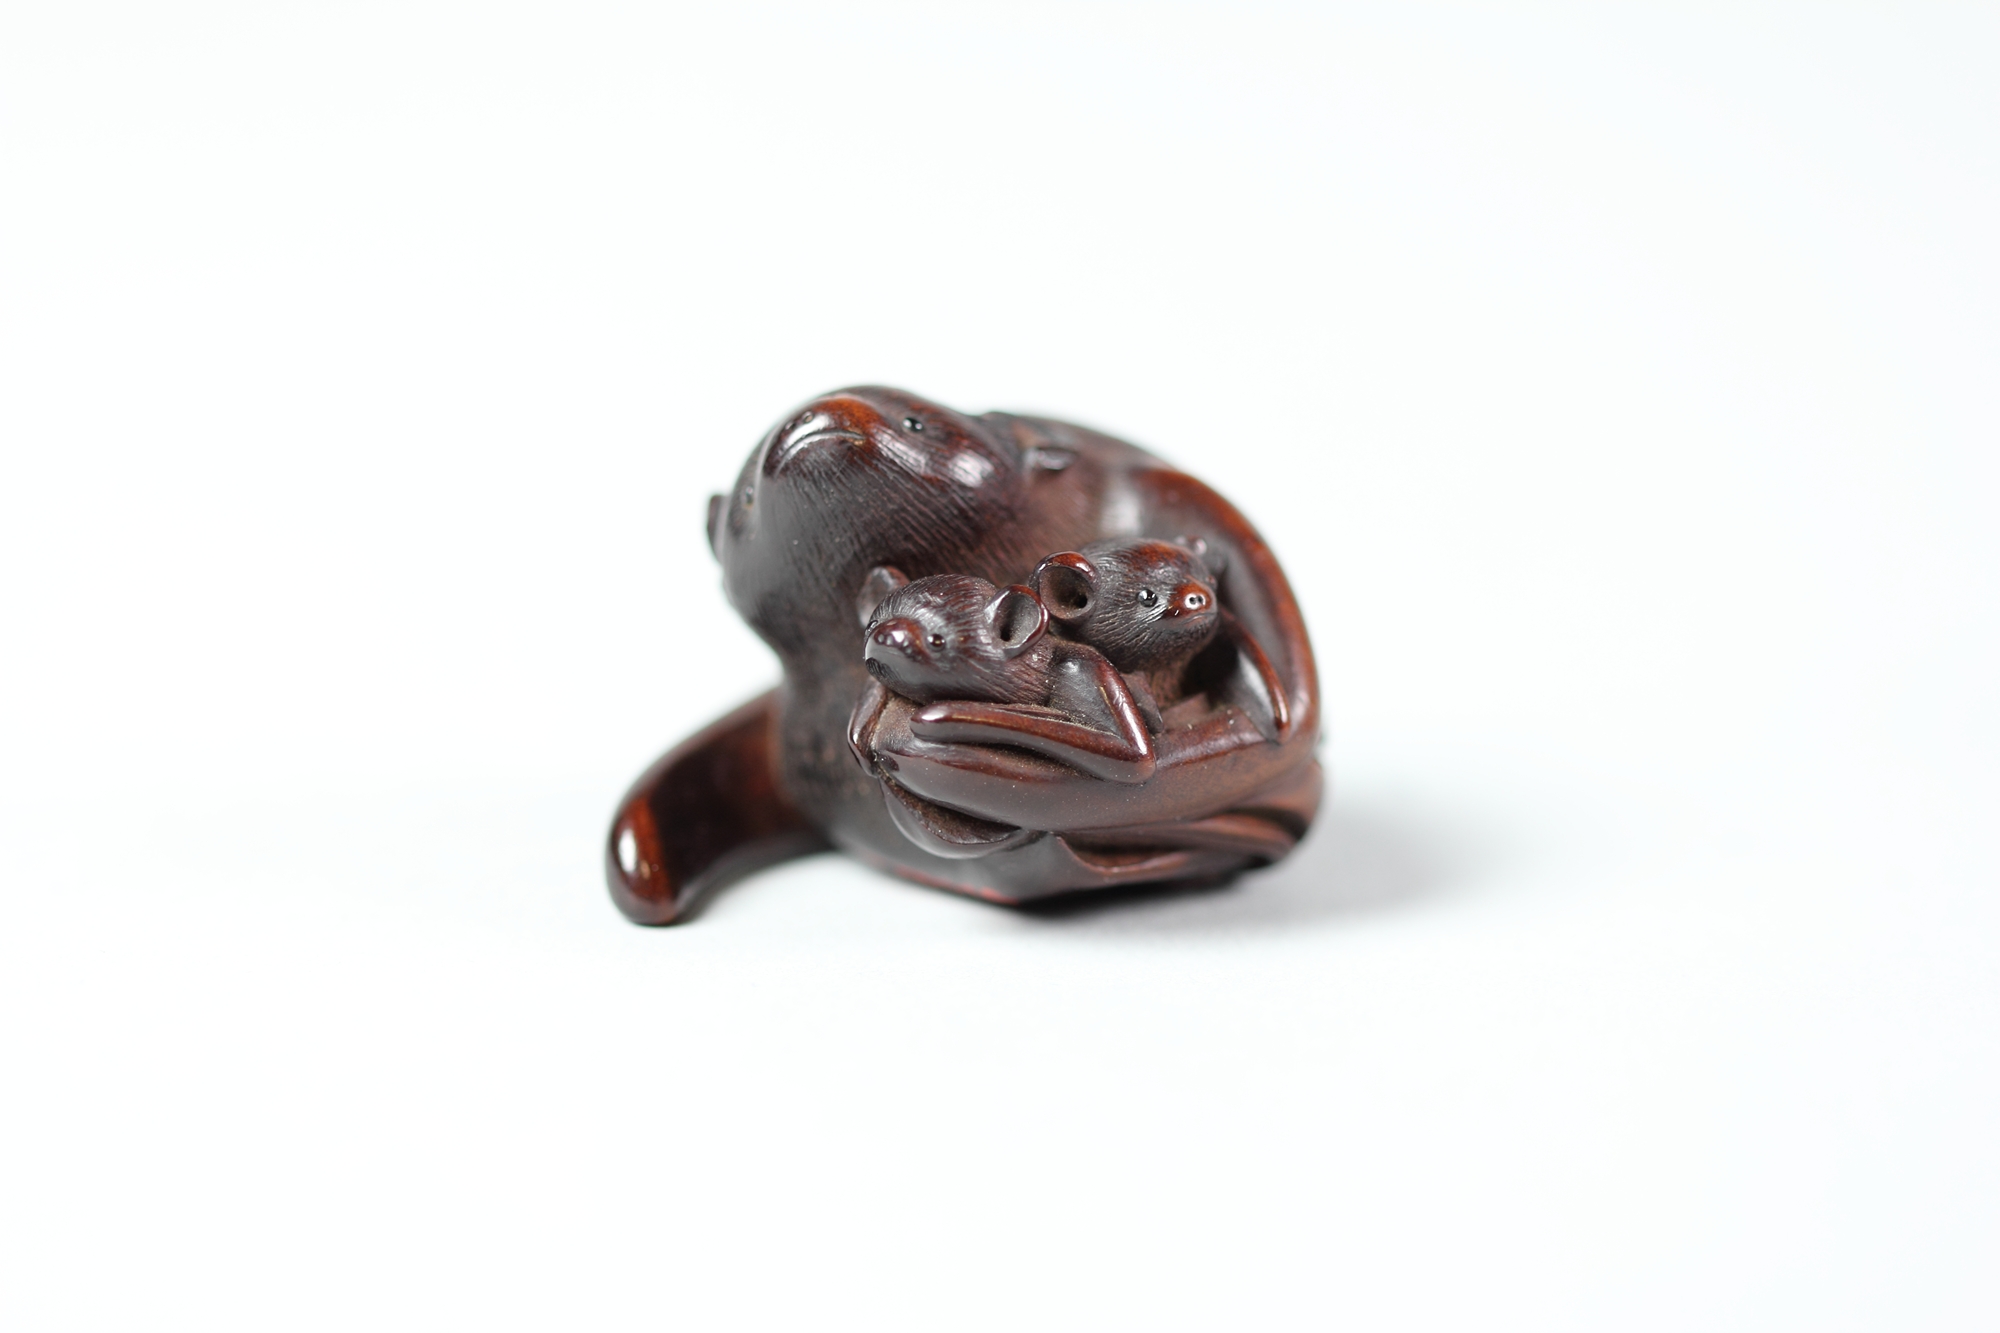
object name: netsuke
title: Netsuke of Mother Bat with Two Young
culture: japanese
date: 1801-1900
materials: wood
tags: bats